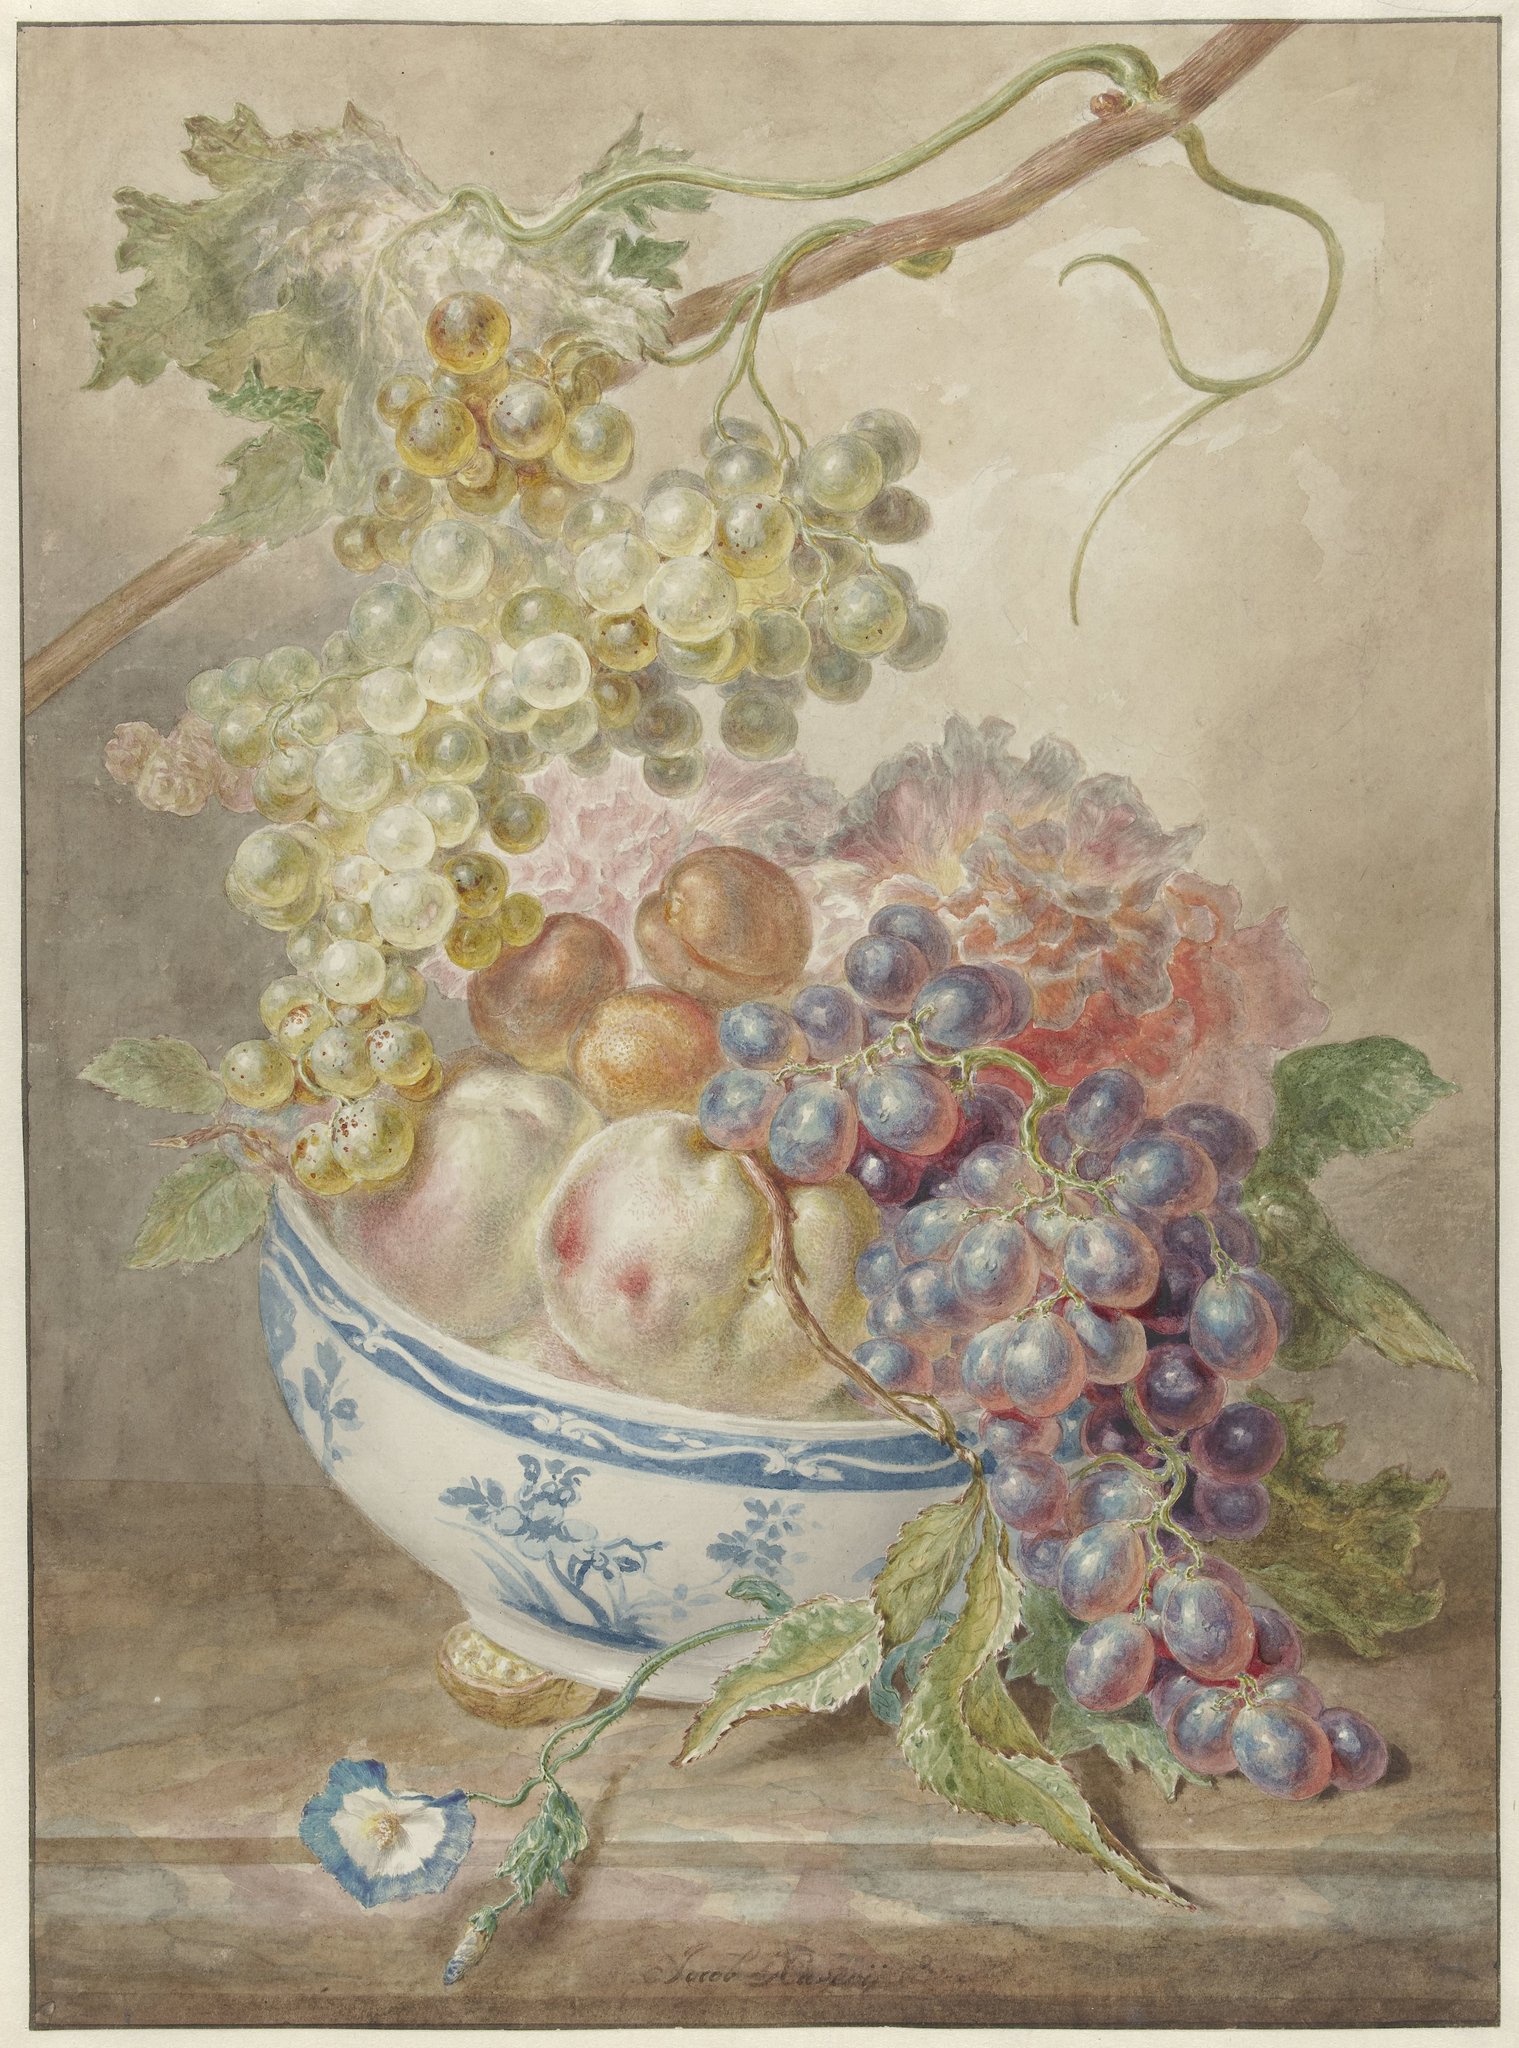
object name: watercolor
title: Schaal met fruit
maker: jacob xavery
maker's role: draughtsman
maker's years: 1736-1769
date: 1746-1769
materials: paper, watercolor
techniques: brush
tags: still life of plants, flowers and fruit